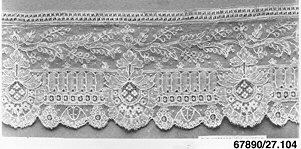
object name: strip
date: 1801-1900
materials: lace